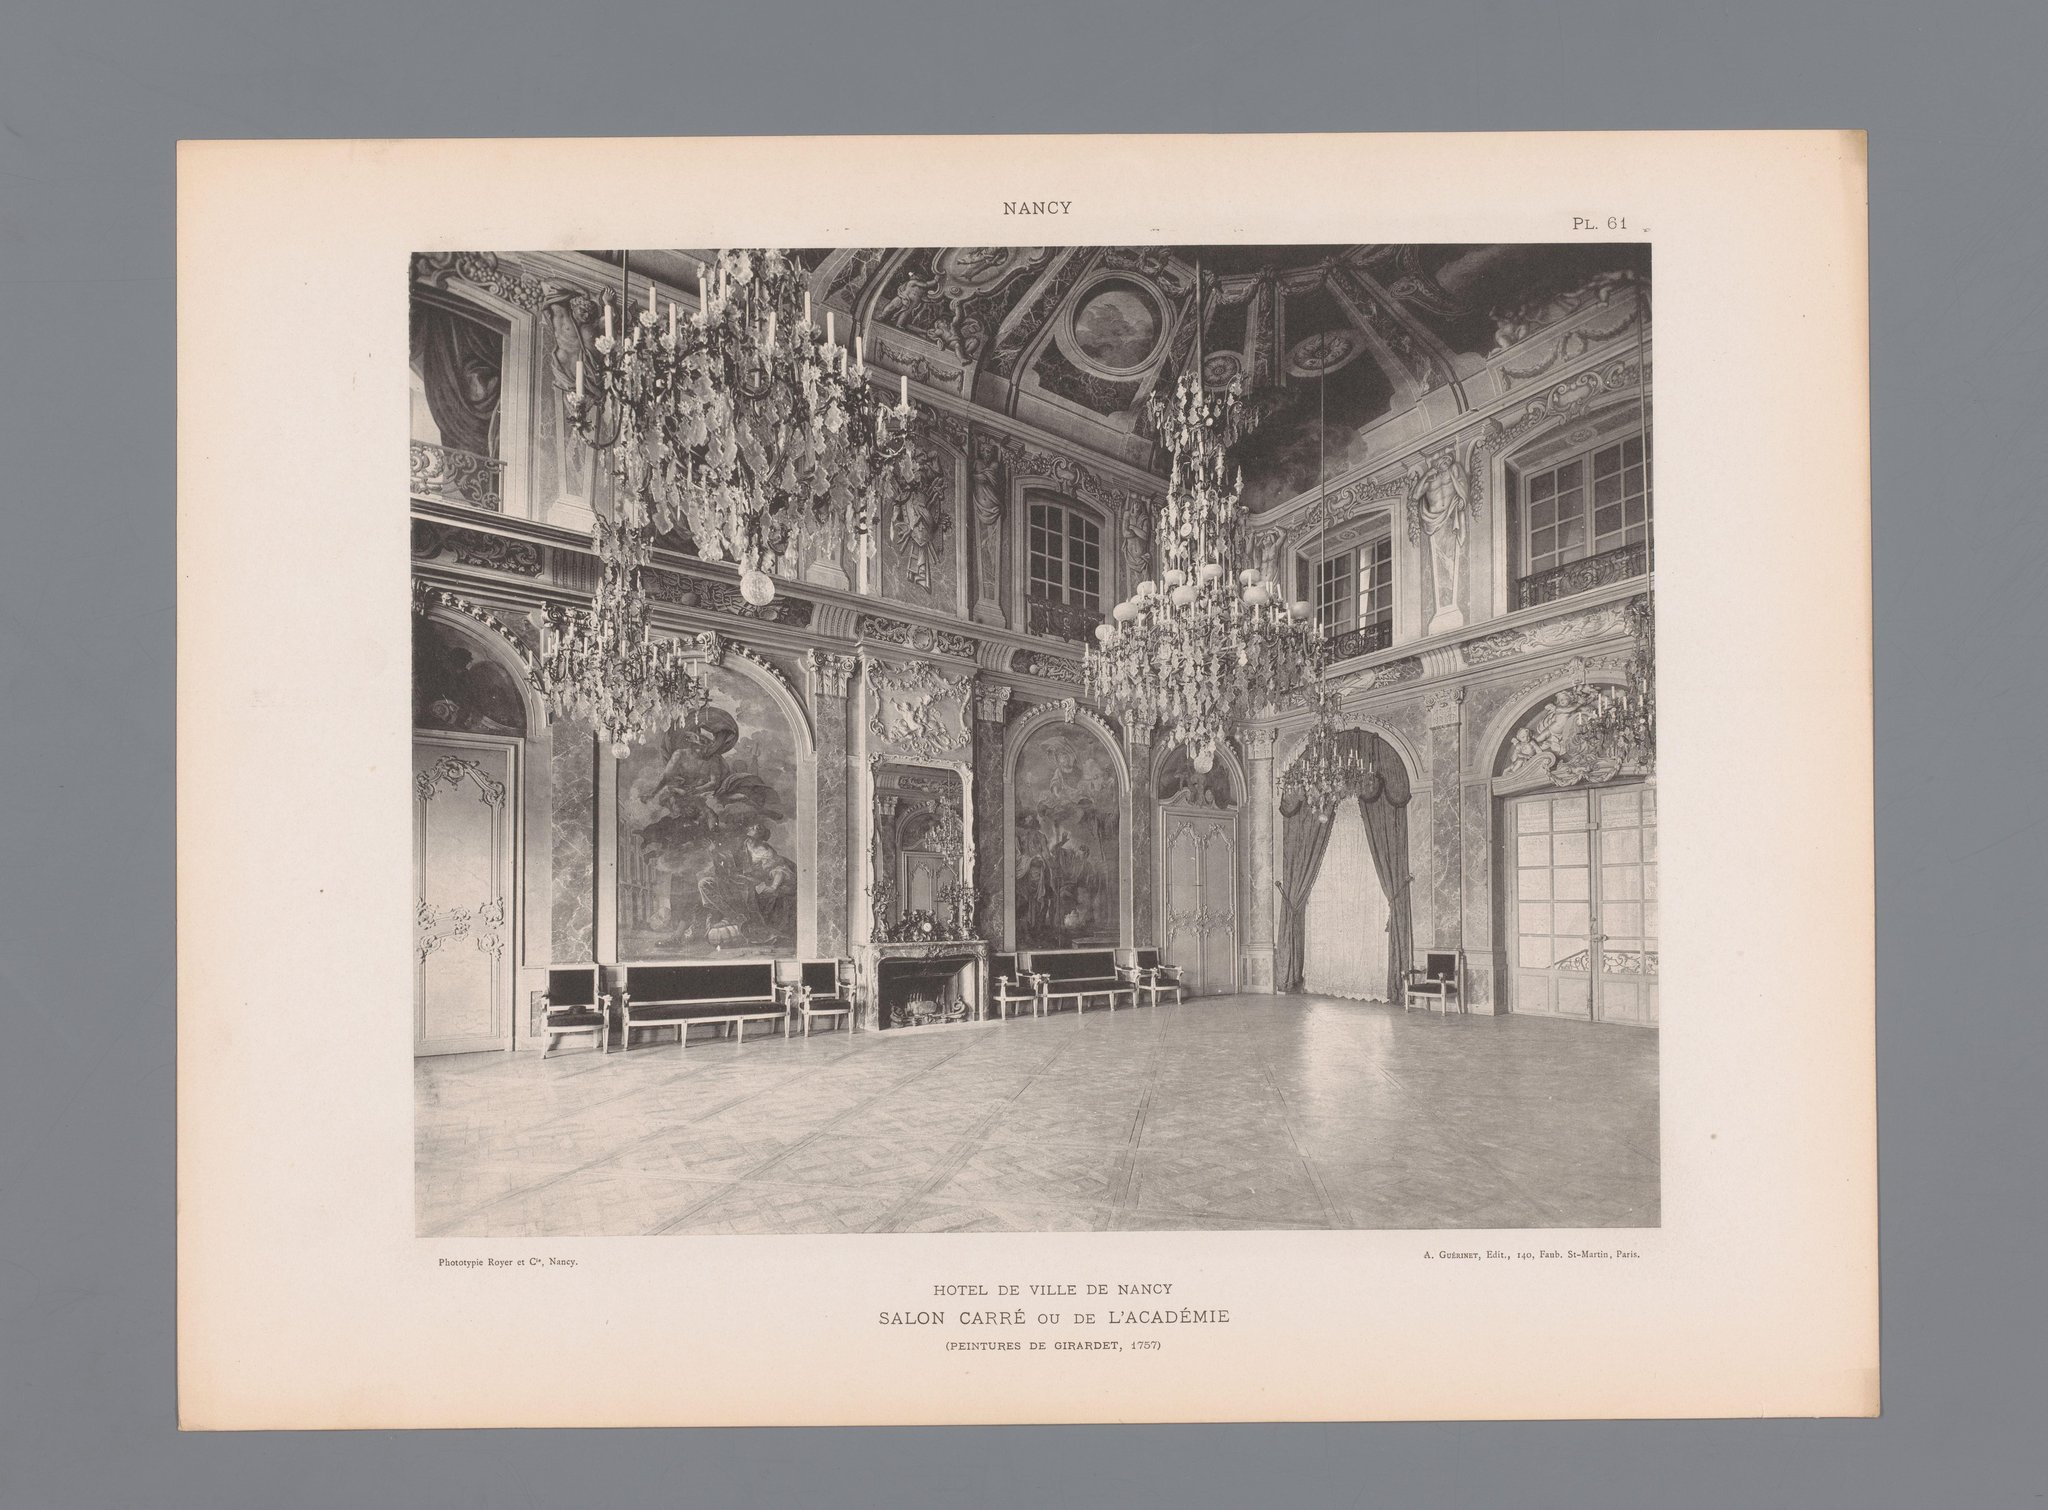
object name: photomechanical print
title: Interieur van een zaal in het stadhuis te Nancy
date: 1891-1896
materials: paper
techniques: photograph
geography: nancy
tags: townhall, vestibule, hall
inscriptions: inscription: ‘Hotel de ville de Nancy/ Salon carré ou de l'académie/ (peintures de Girardet, 1757)’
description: Deze prent maakt deel uit van een omslag met 103 prenten op 101 bladen en een titelblad.